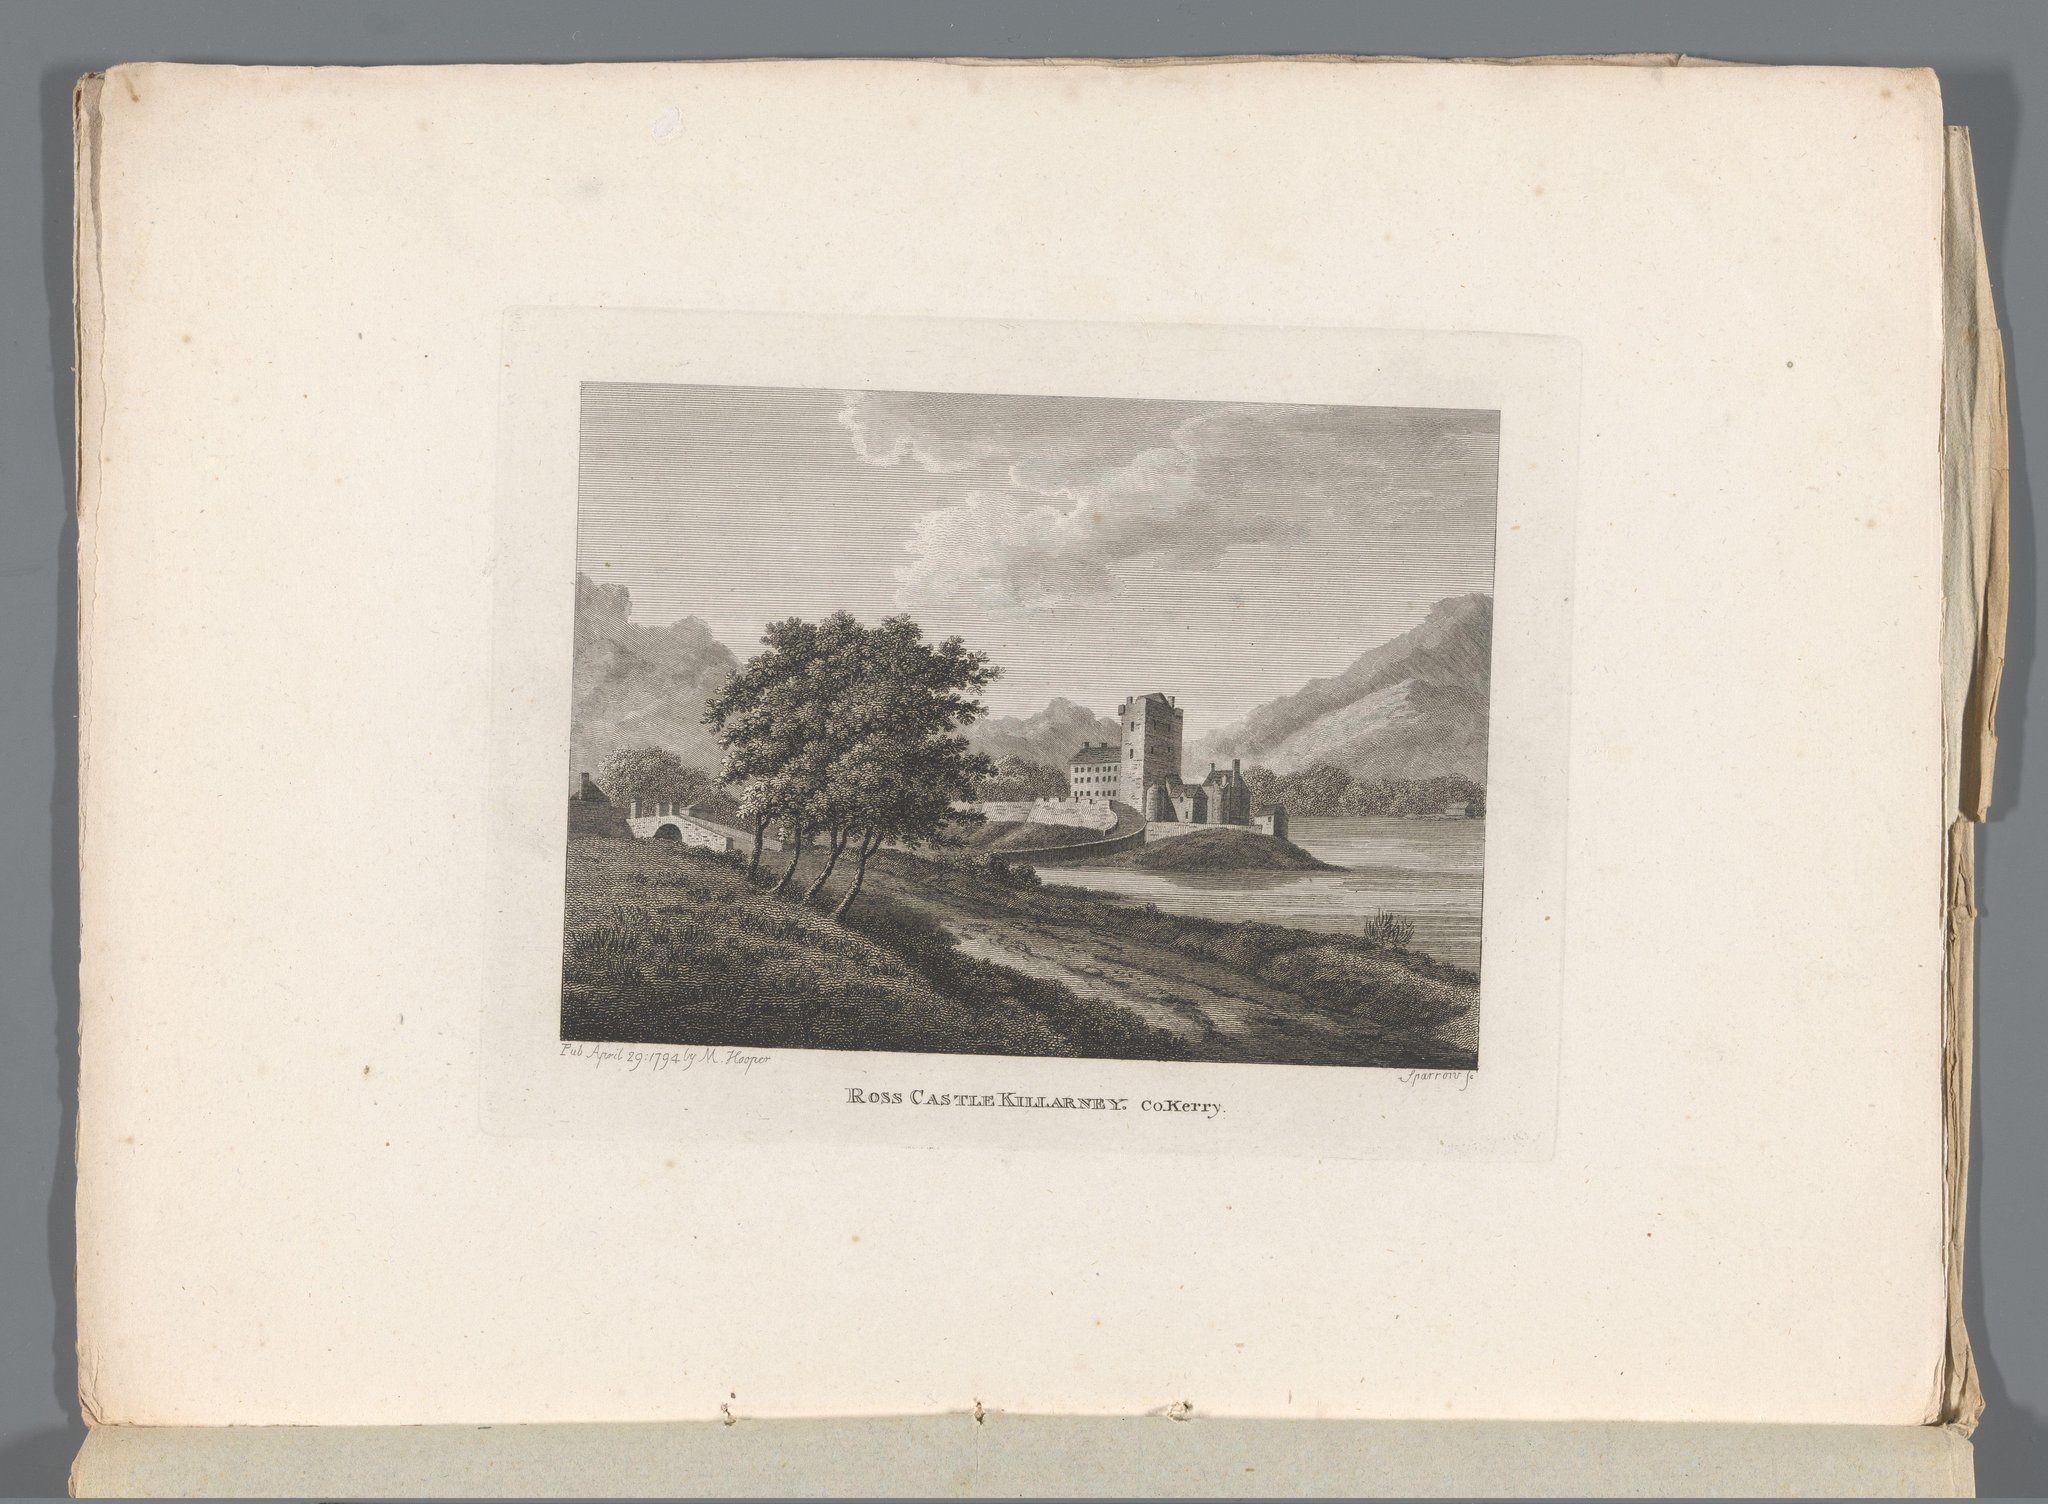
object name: book illustration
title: Gezicht op Ross Castle in Killarney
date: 1794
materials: paper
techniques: etching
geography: london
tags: landscape with tower or castle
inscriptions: date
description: Prent verschenen in: Grose, Francis. The antiquities of Ireland. Londen: S. Hooper, 1795, dl. 2.